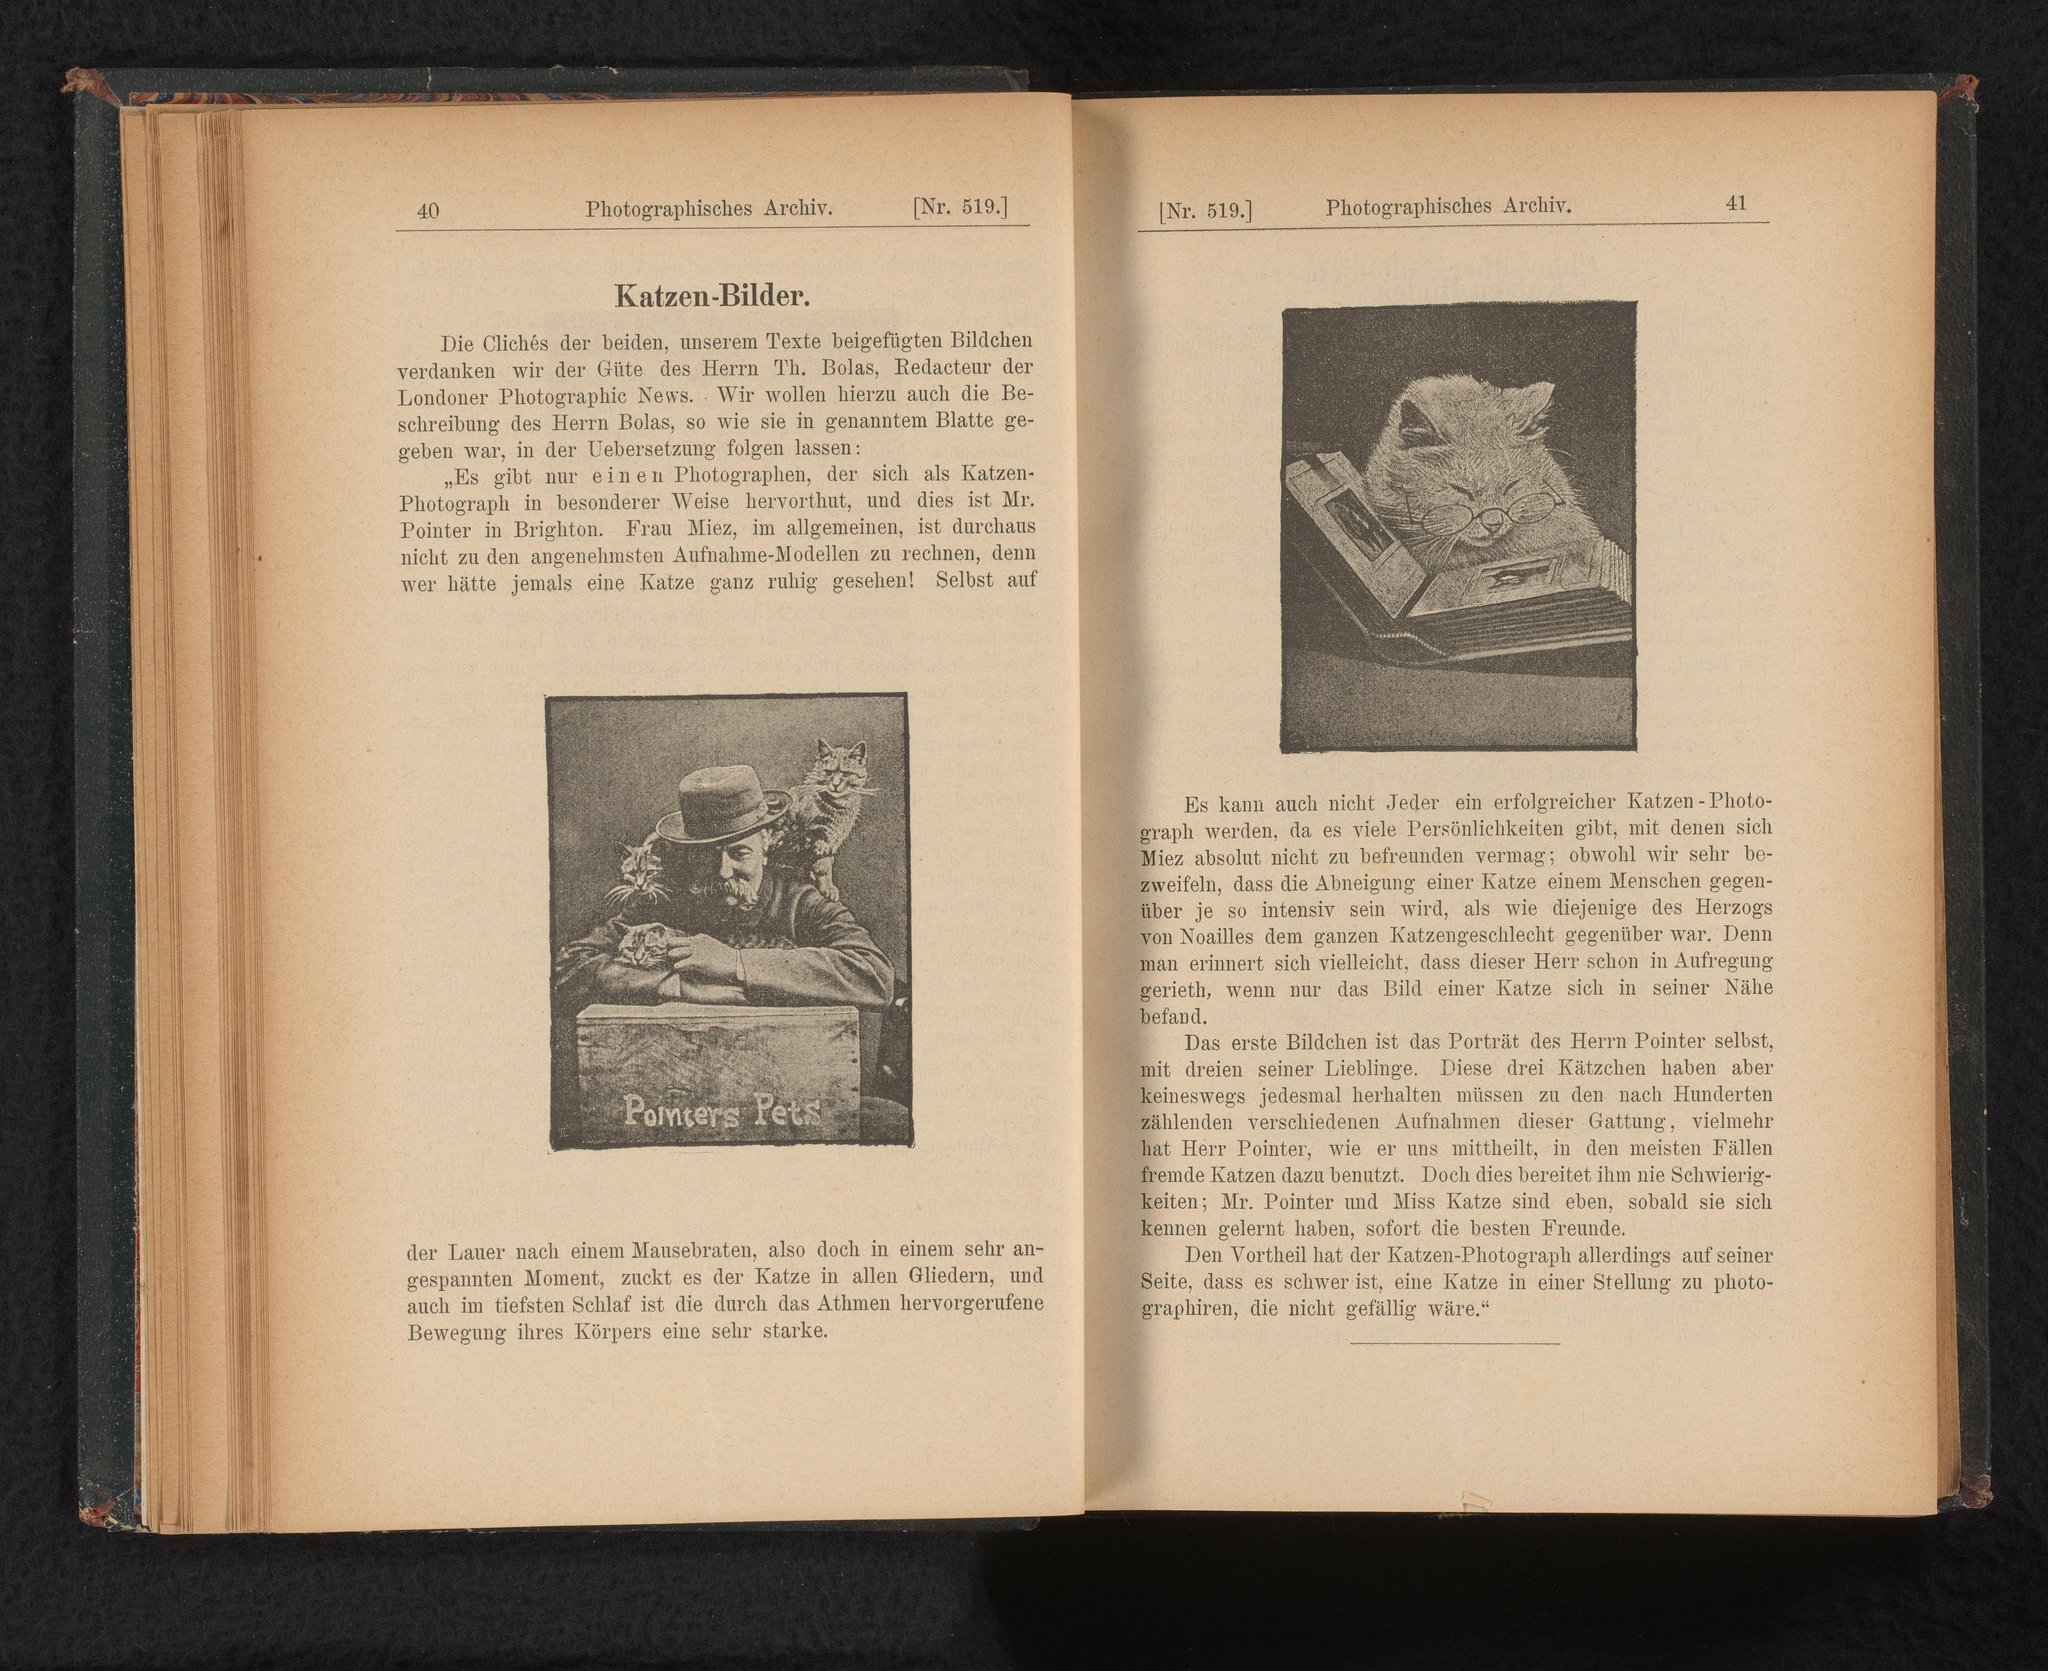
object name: page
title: Portret van Harry Pointer met drie katten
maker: Anonymous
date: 1880-1885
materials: paper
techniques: autotype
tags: harry pointer, cat, historical persons